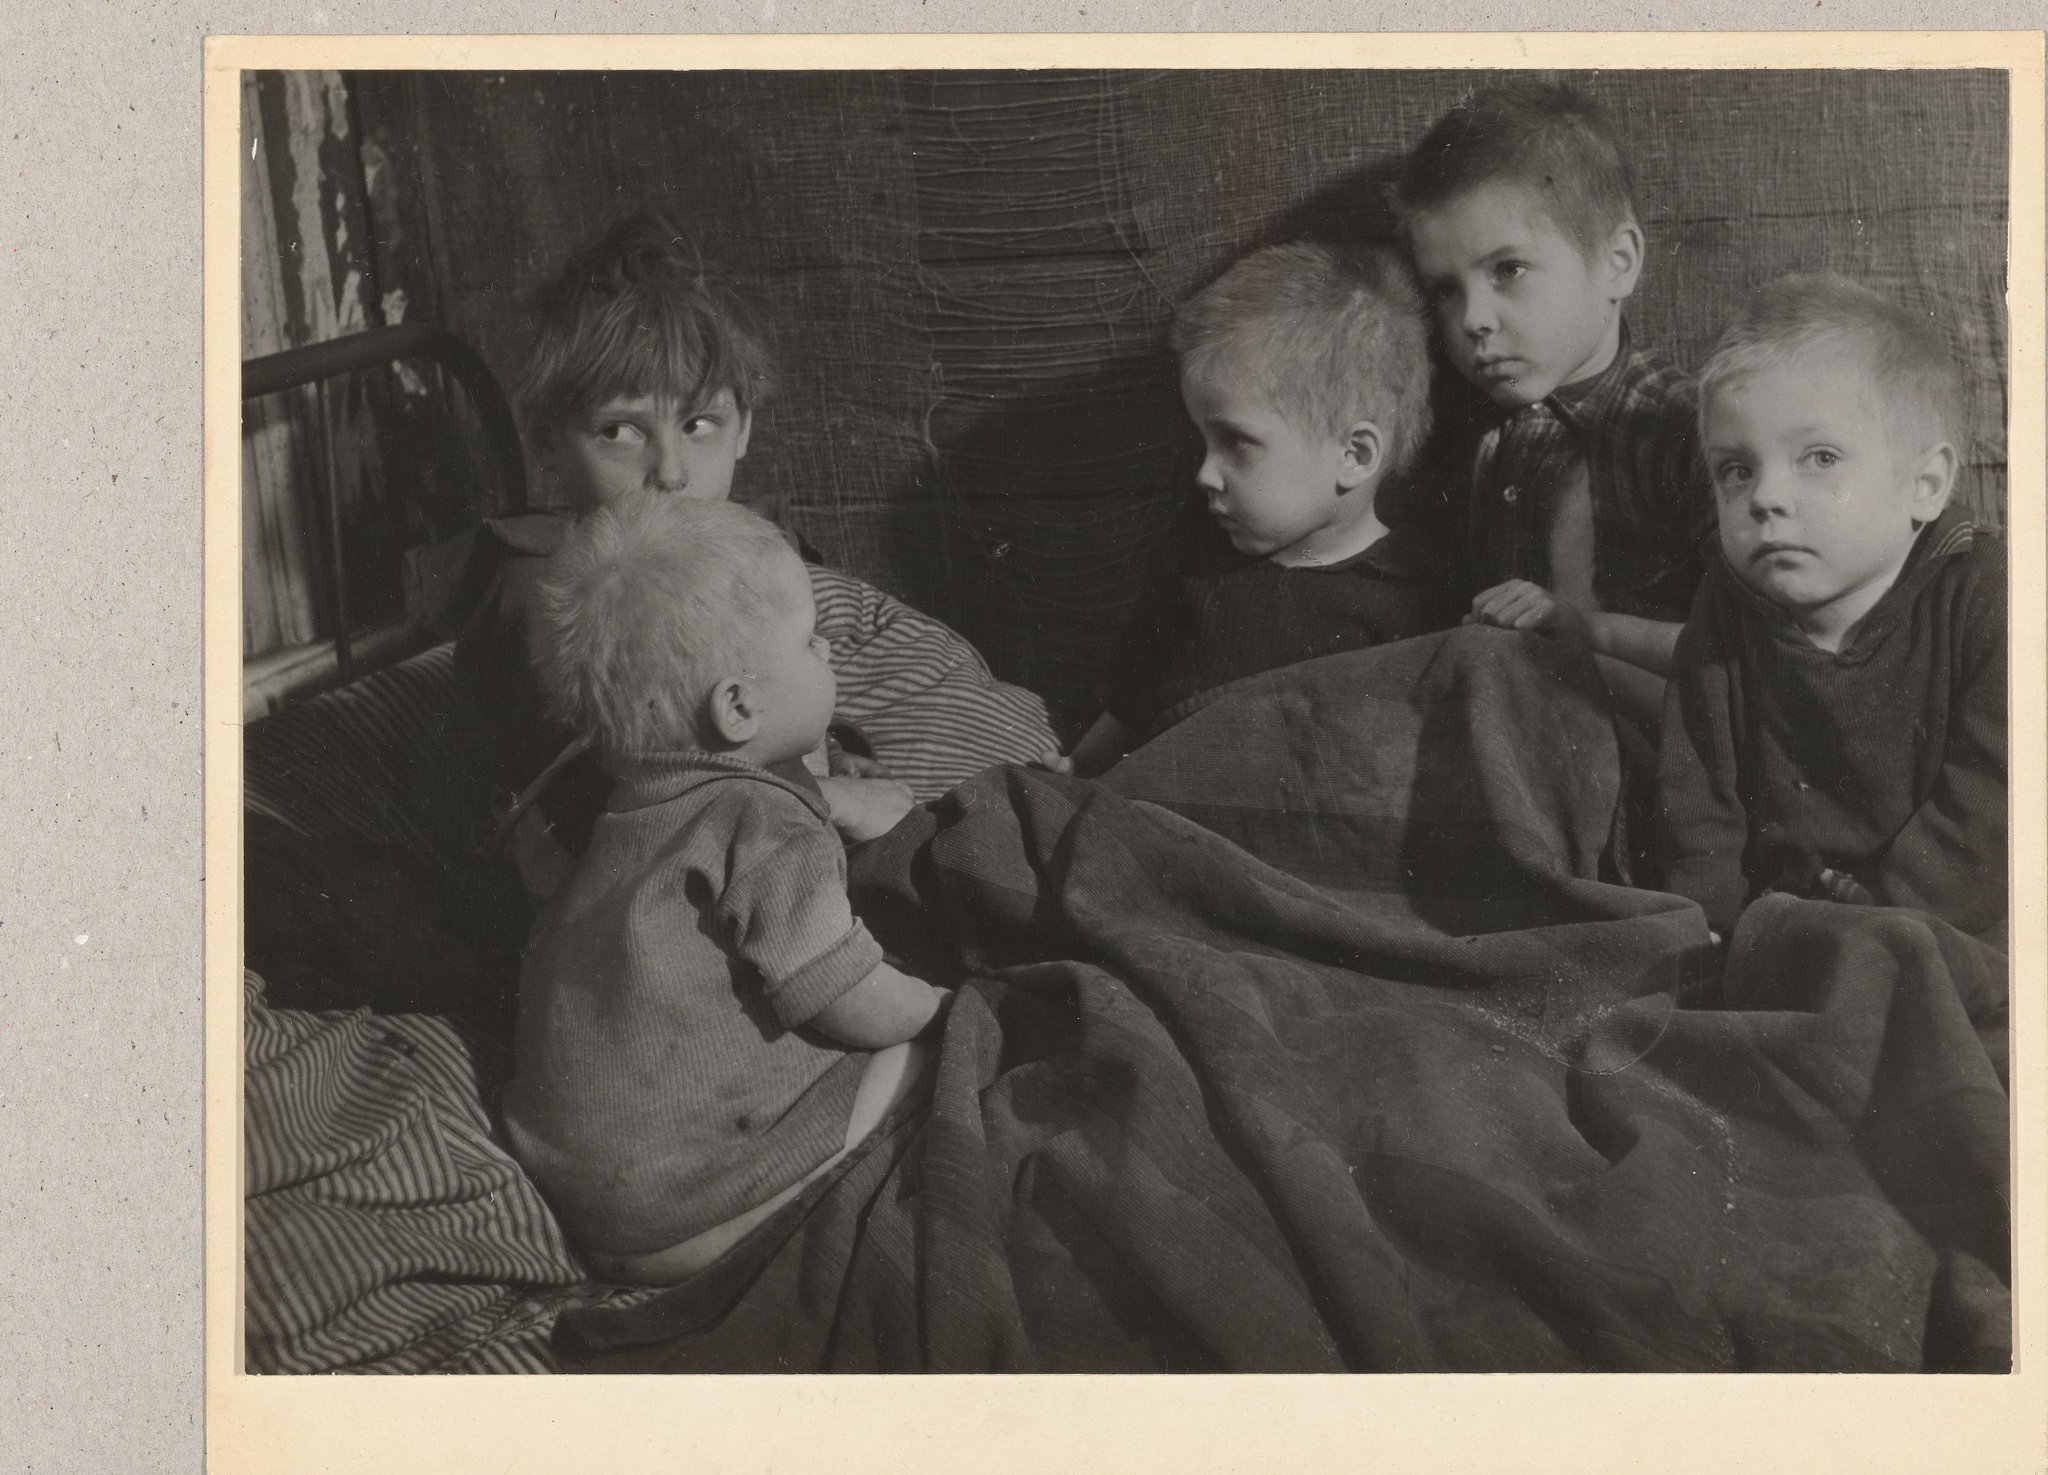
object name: photograph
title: Vijf kinderen onder een deken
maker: emmy eugenie andriesse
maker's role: fotograaf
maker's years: 1914-1953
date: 1940-1945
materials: paper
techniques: gelatin silver print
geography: amsterdam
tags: resting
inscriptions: annotation: ‘WO II NEDERLAND’, annotation: ‘Emmy Andriesse, Amsterdam-c o.z. achterburgwal 192’, annotation: ‘Archief exemplaar Na publicatie gelieve te retourneren aan ABC Press, Amsterdam-c n.z. voorburgwal’